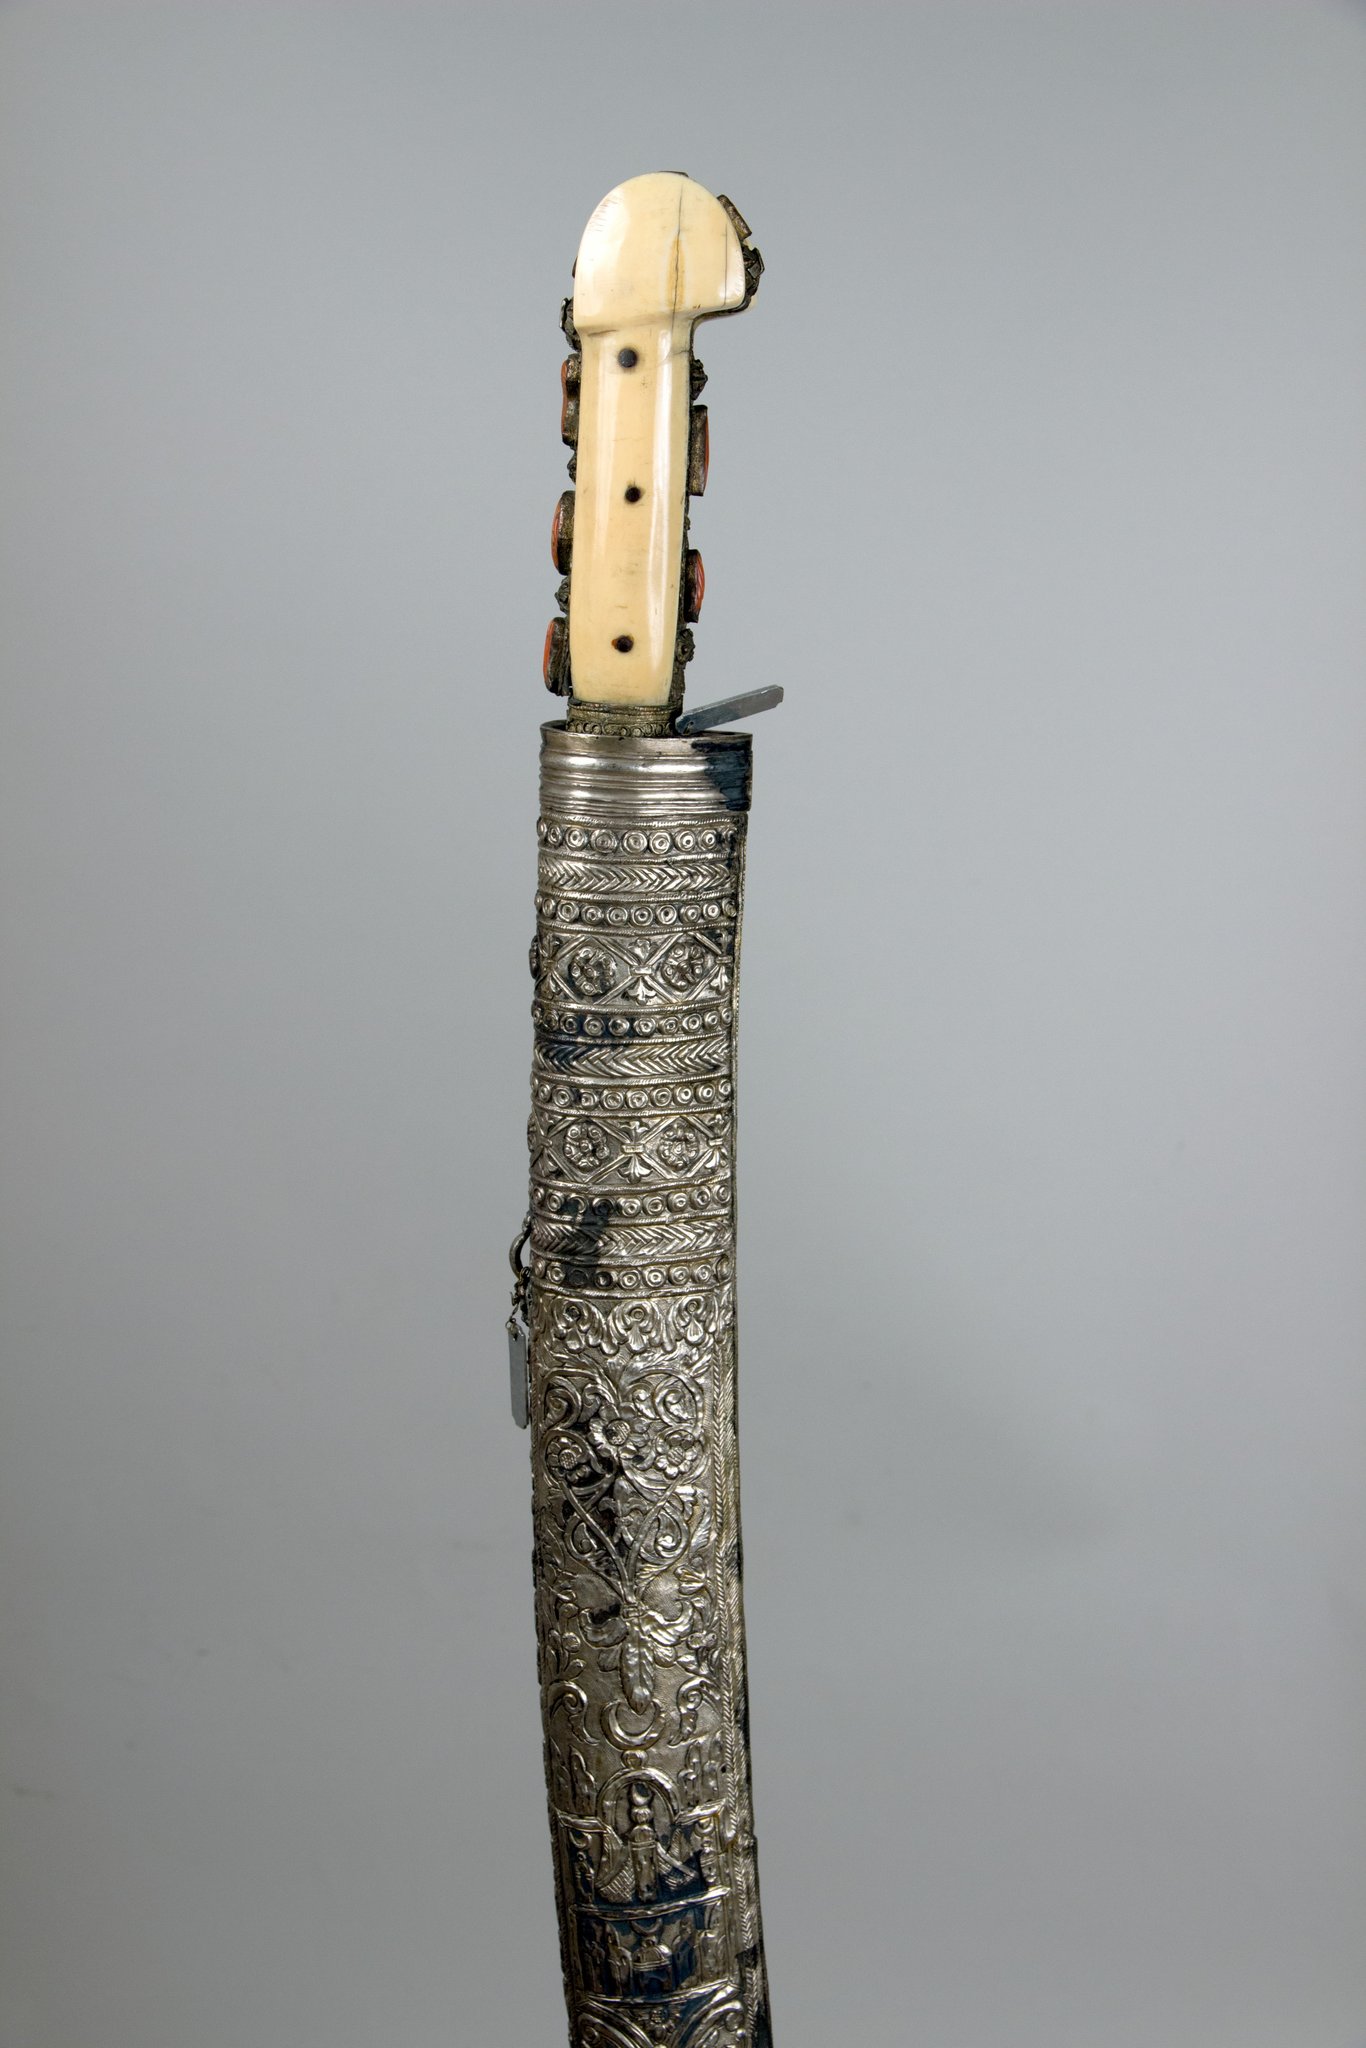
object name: sword yatagan with scabbard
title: Sword (Yatagan) with Scabbard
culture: turkish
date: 1701-1900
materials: copper, coral, ivory, silver, steel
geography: ottoman empire